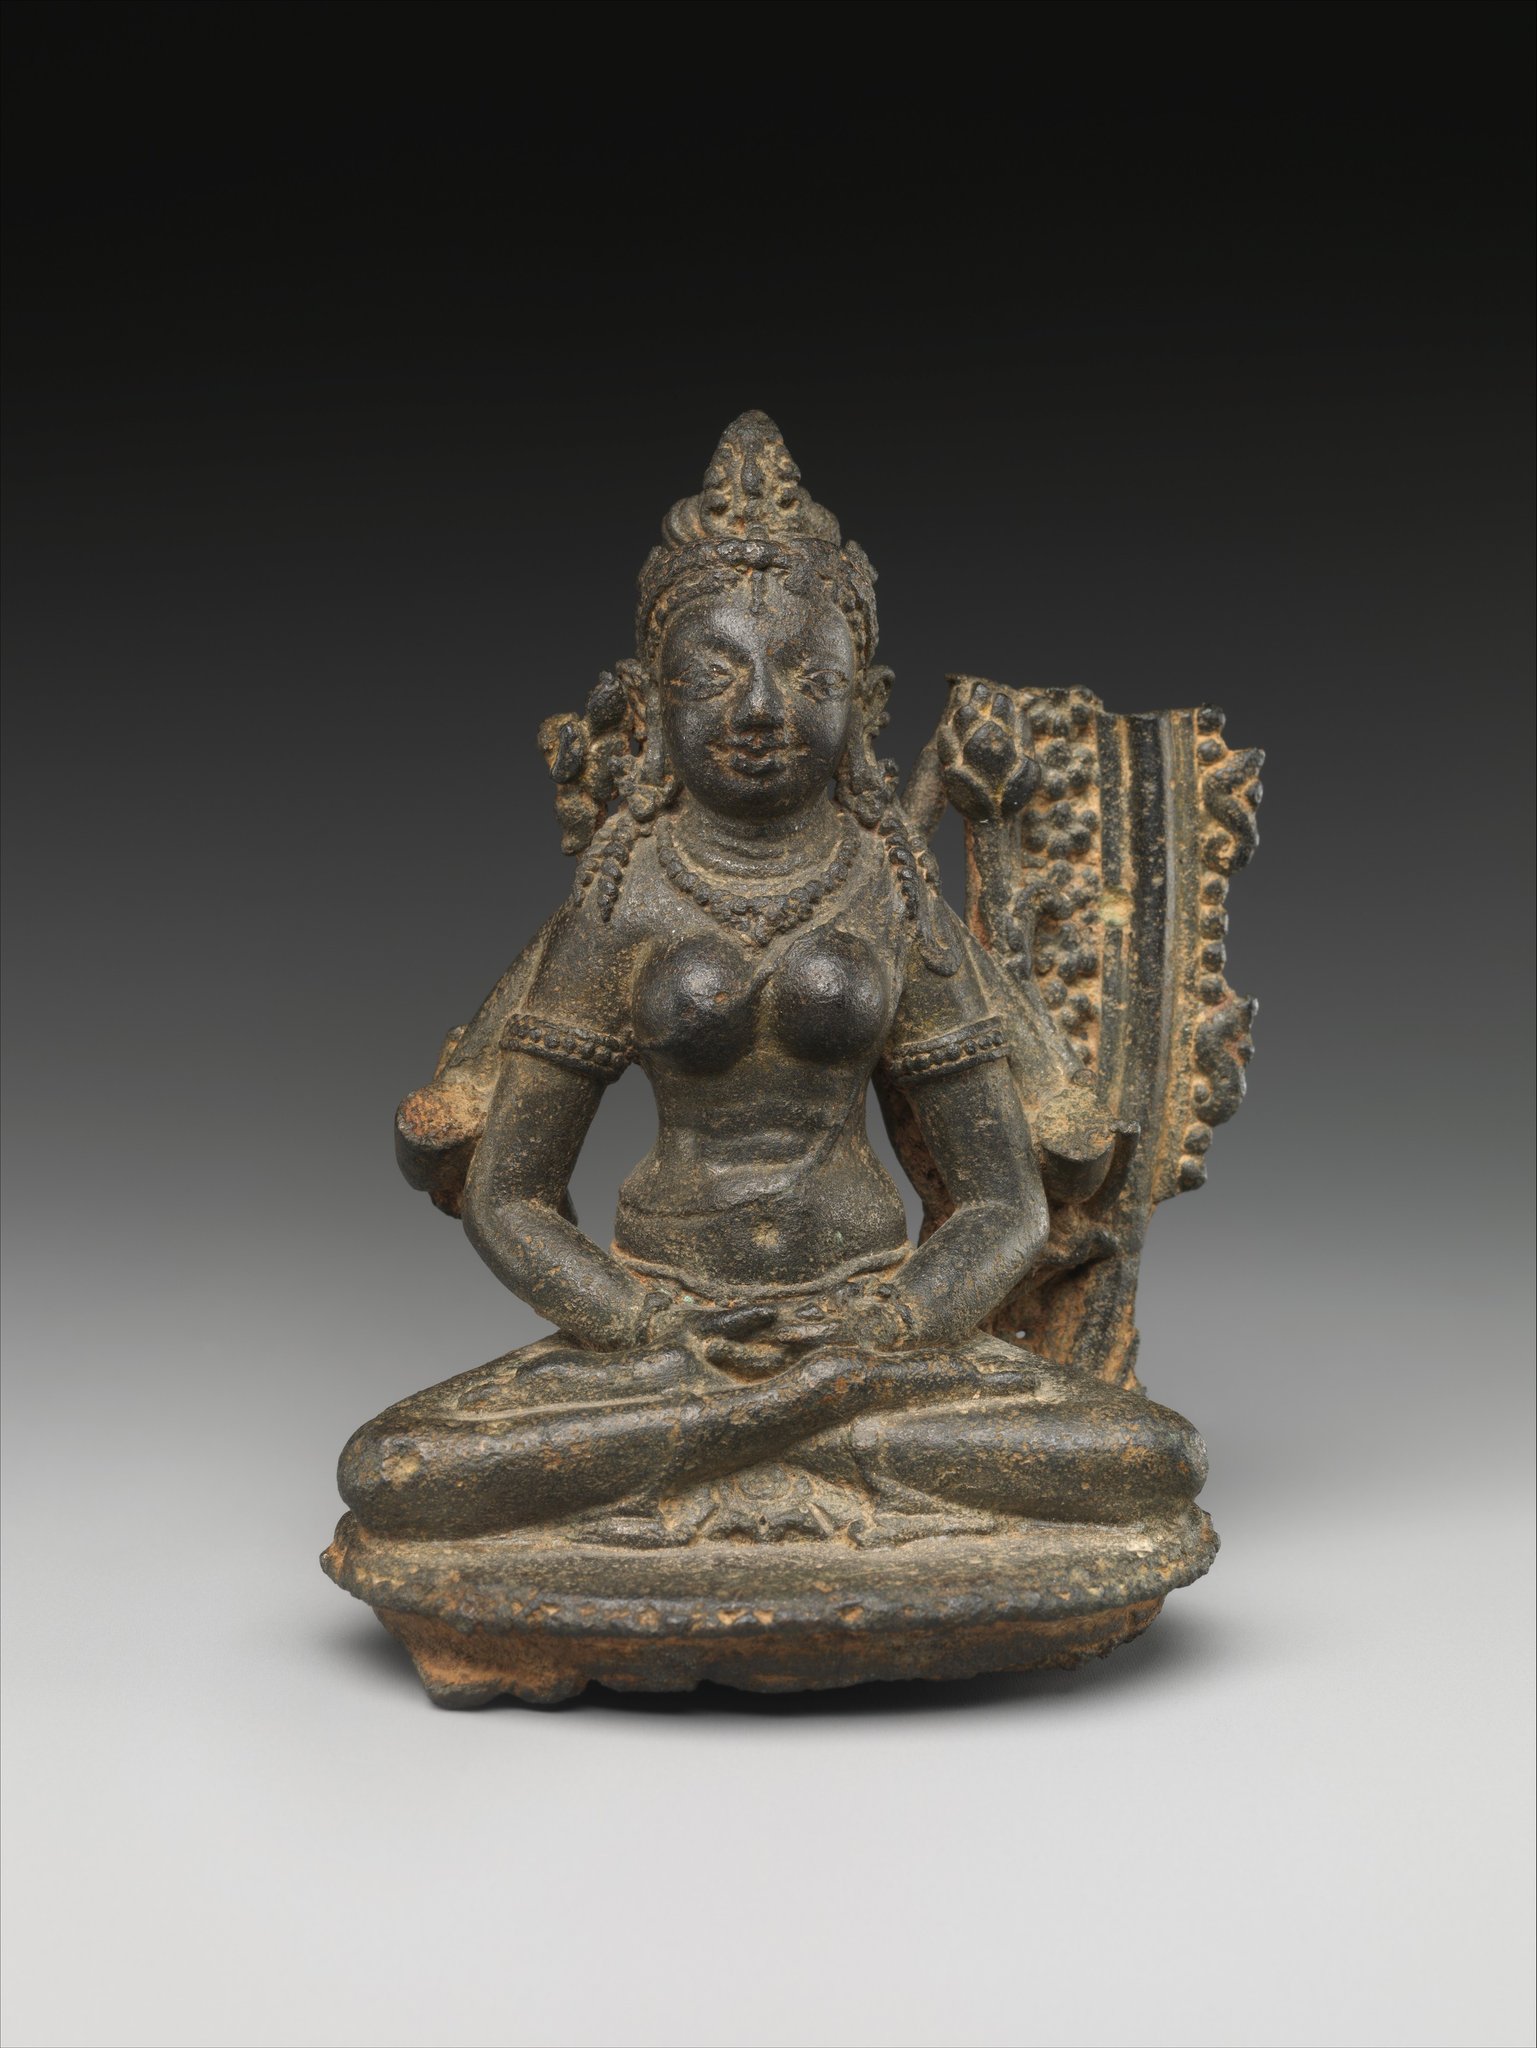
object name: figurine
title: Seated Multi-Armed Tara (The Buddhist Savioress)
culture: indian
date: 801-900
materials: bronze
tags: buddhism,deities